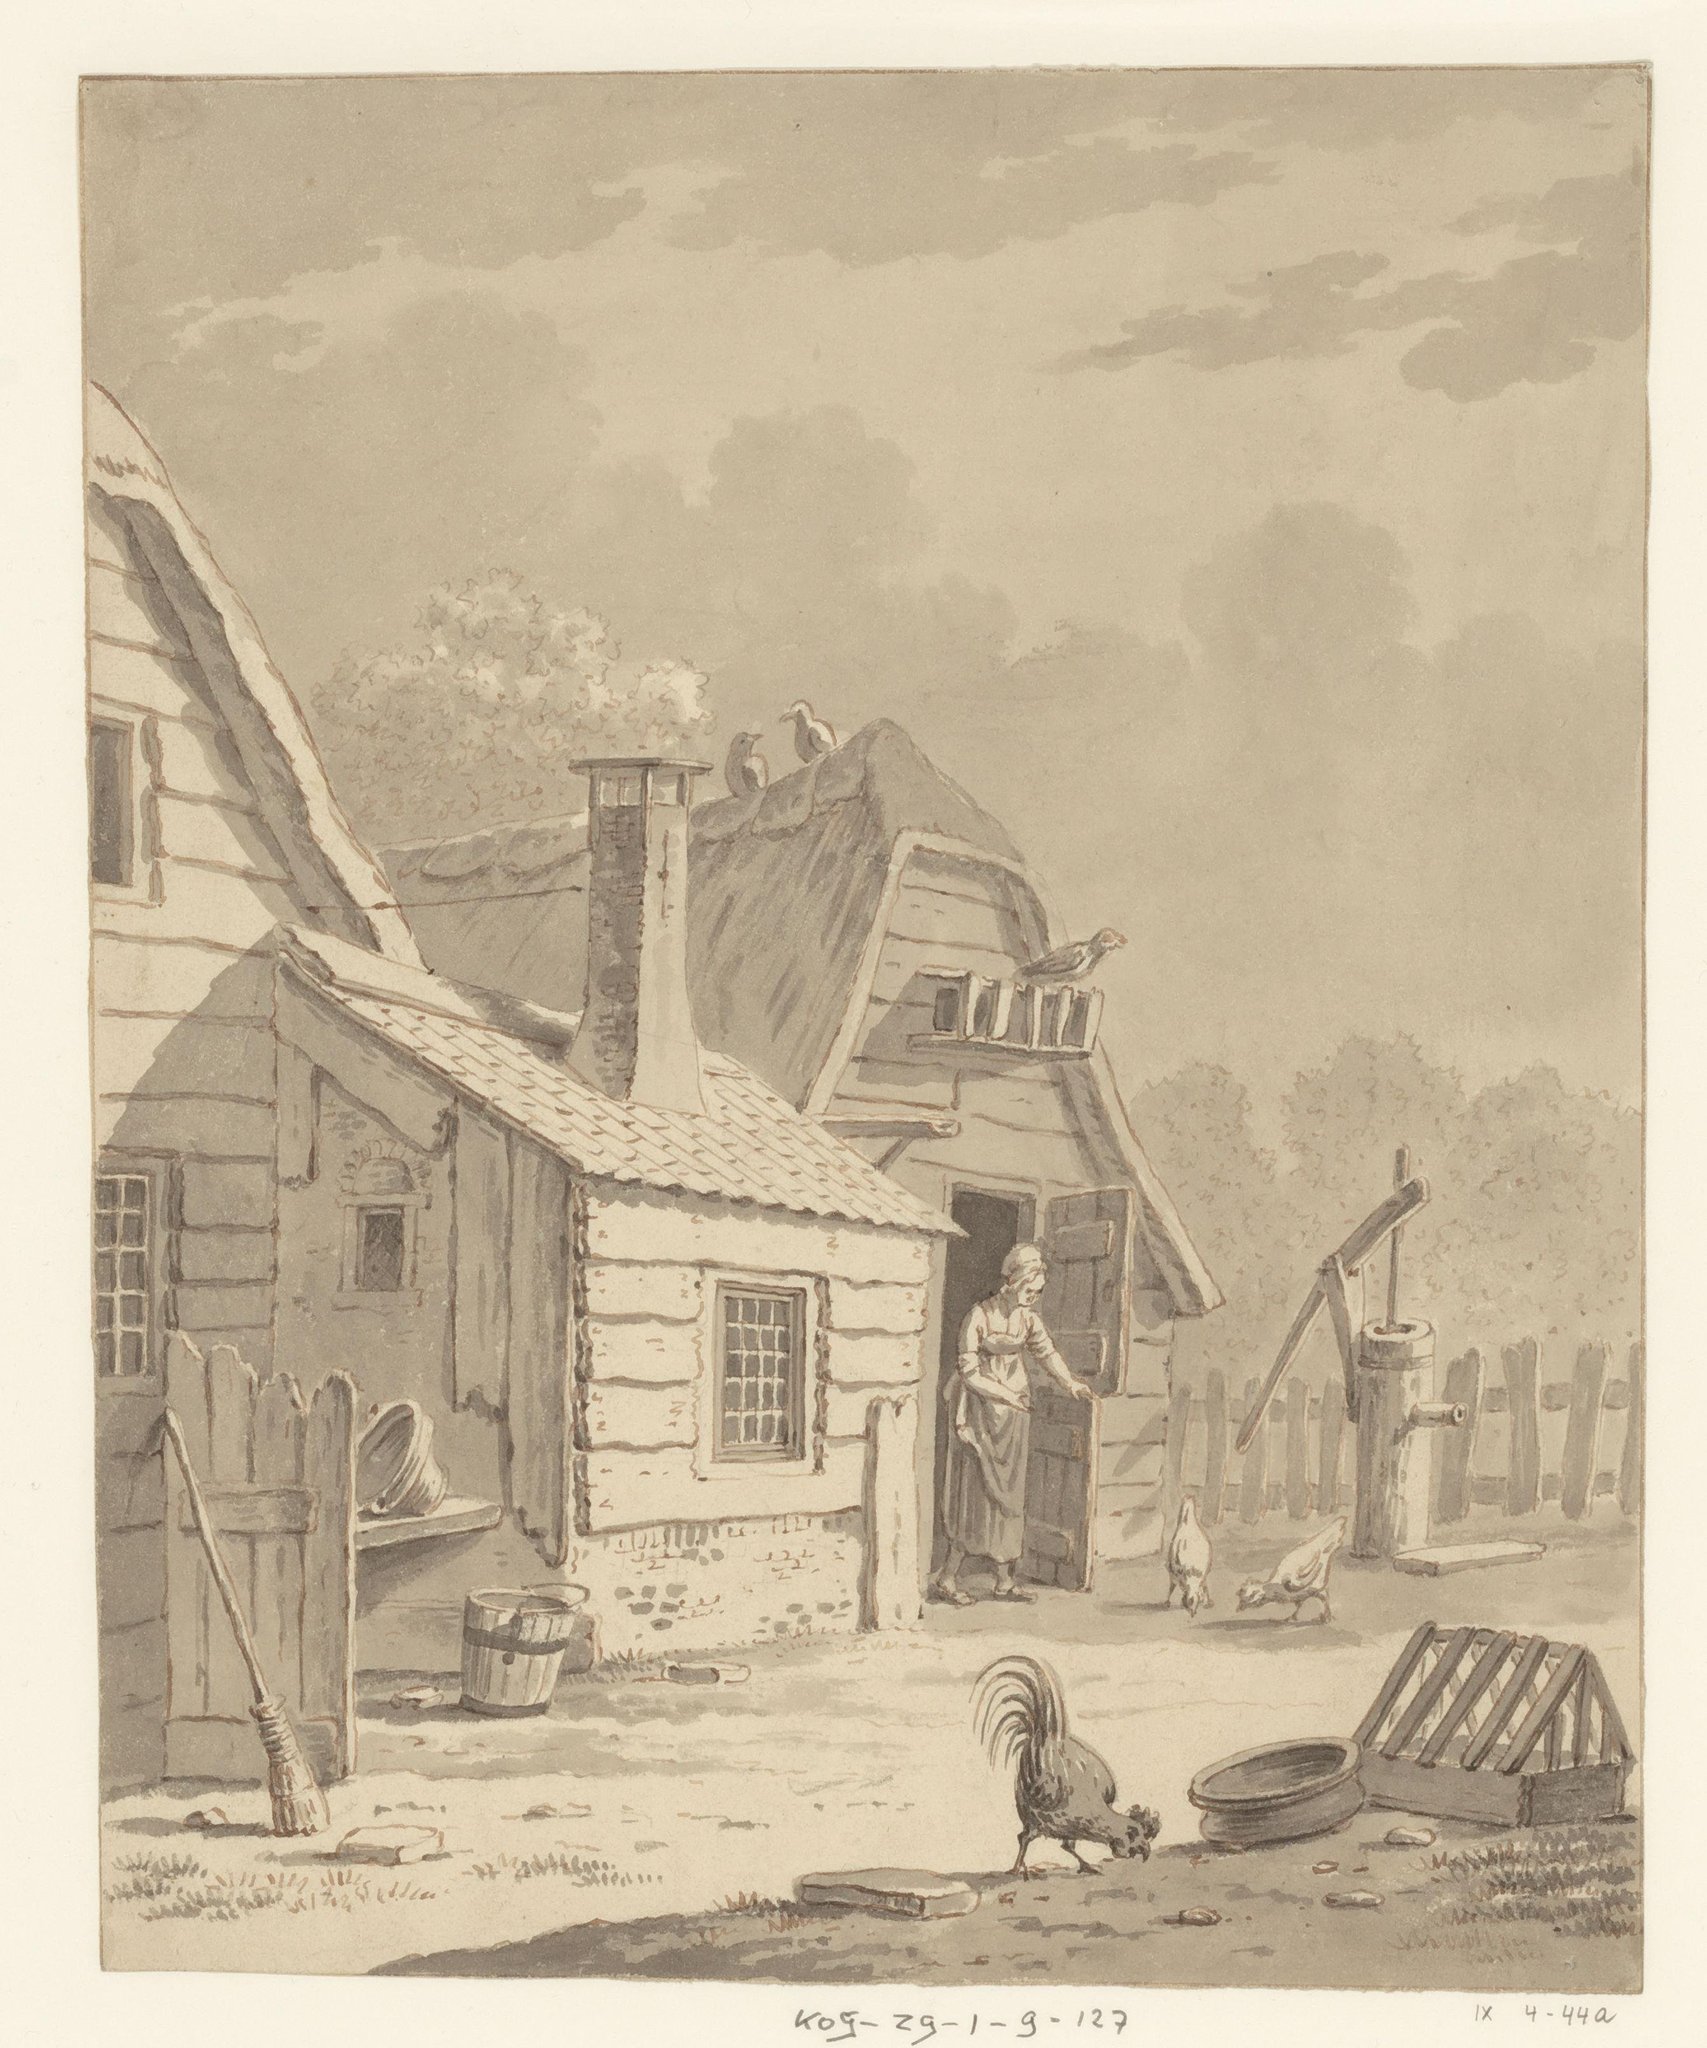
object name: drawing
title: Boerin en kippen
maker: Anonymous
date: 1800-1899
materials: ink, paper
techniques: brush, pen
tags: barn, farmers - aa - female farmer, farmer's wife, fowl (cock, hen, chicken, etc.)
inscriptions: collector's mark: Lugt 1641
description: Onderwerpsrubrieken binnen de Atlas Zeden en Gewoonten: Handel, nijverheid en verkeer, Boerenleven.